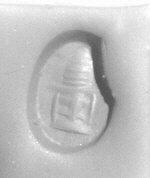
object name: stamp seal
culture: sasanian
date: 201-700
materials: stone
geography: iran or mesopotamia